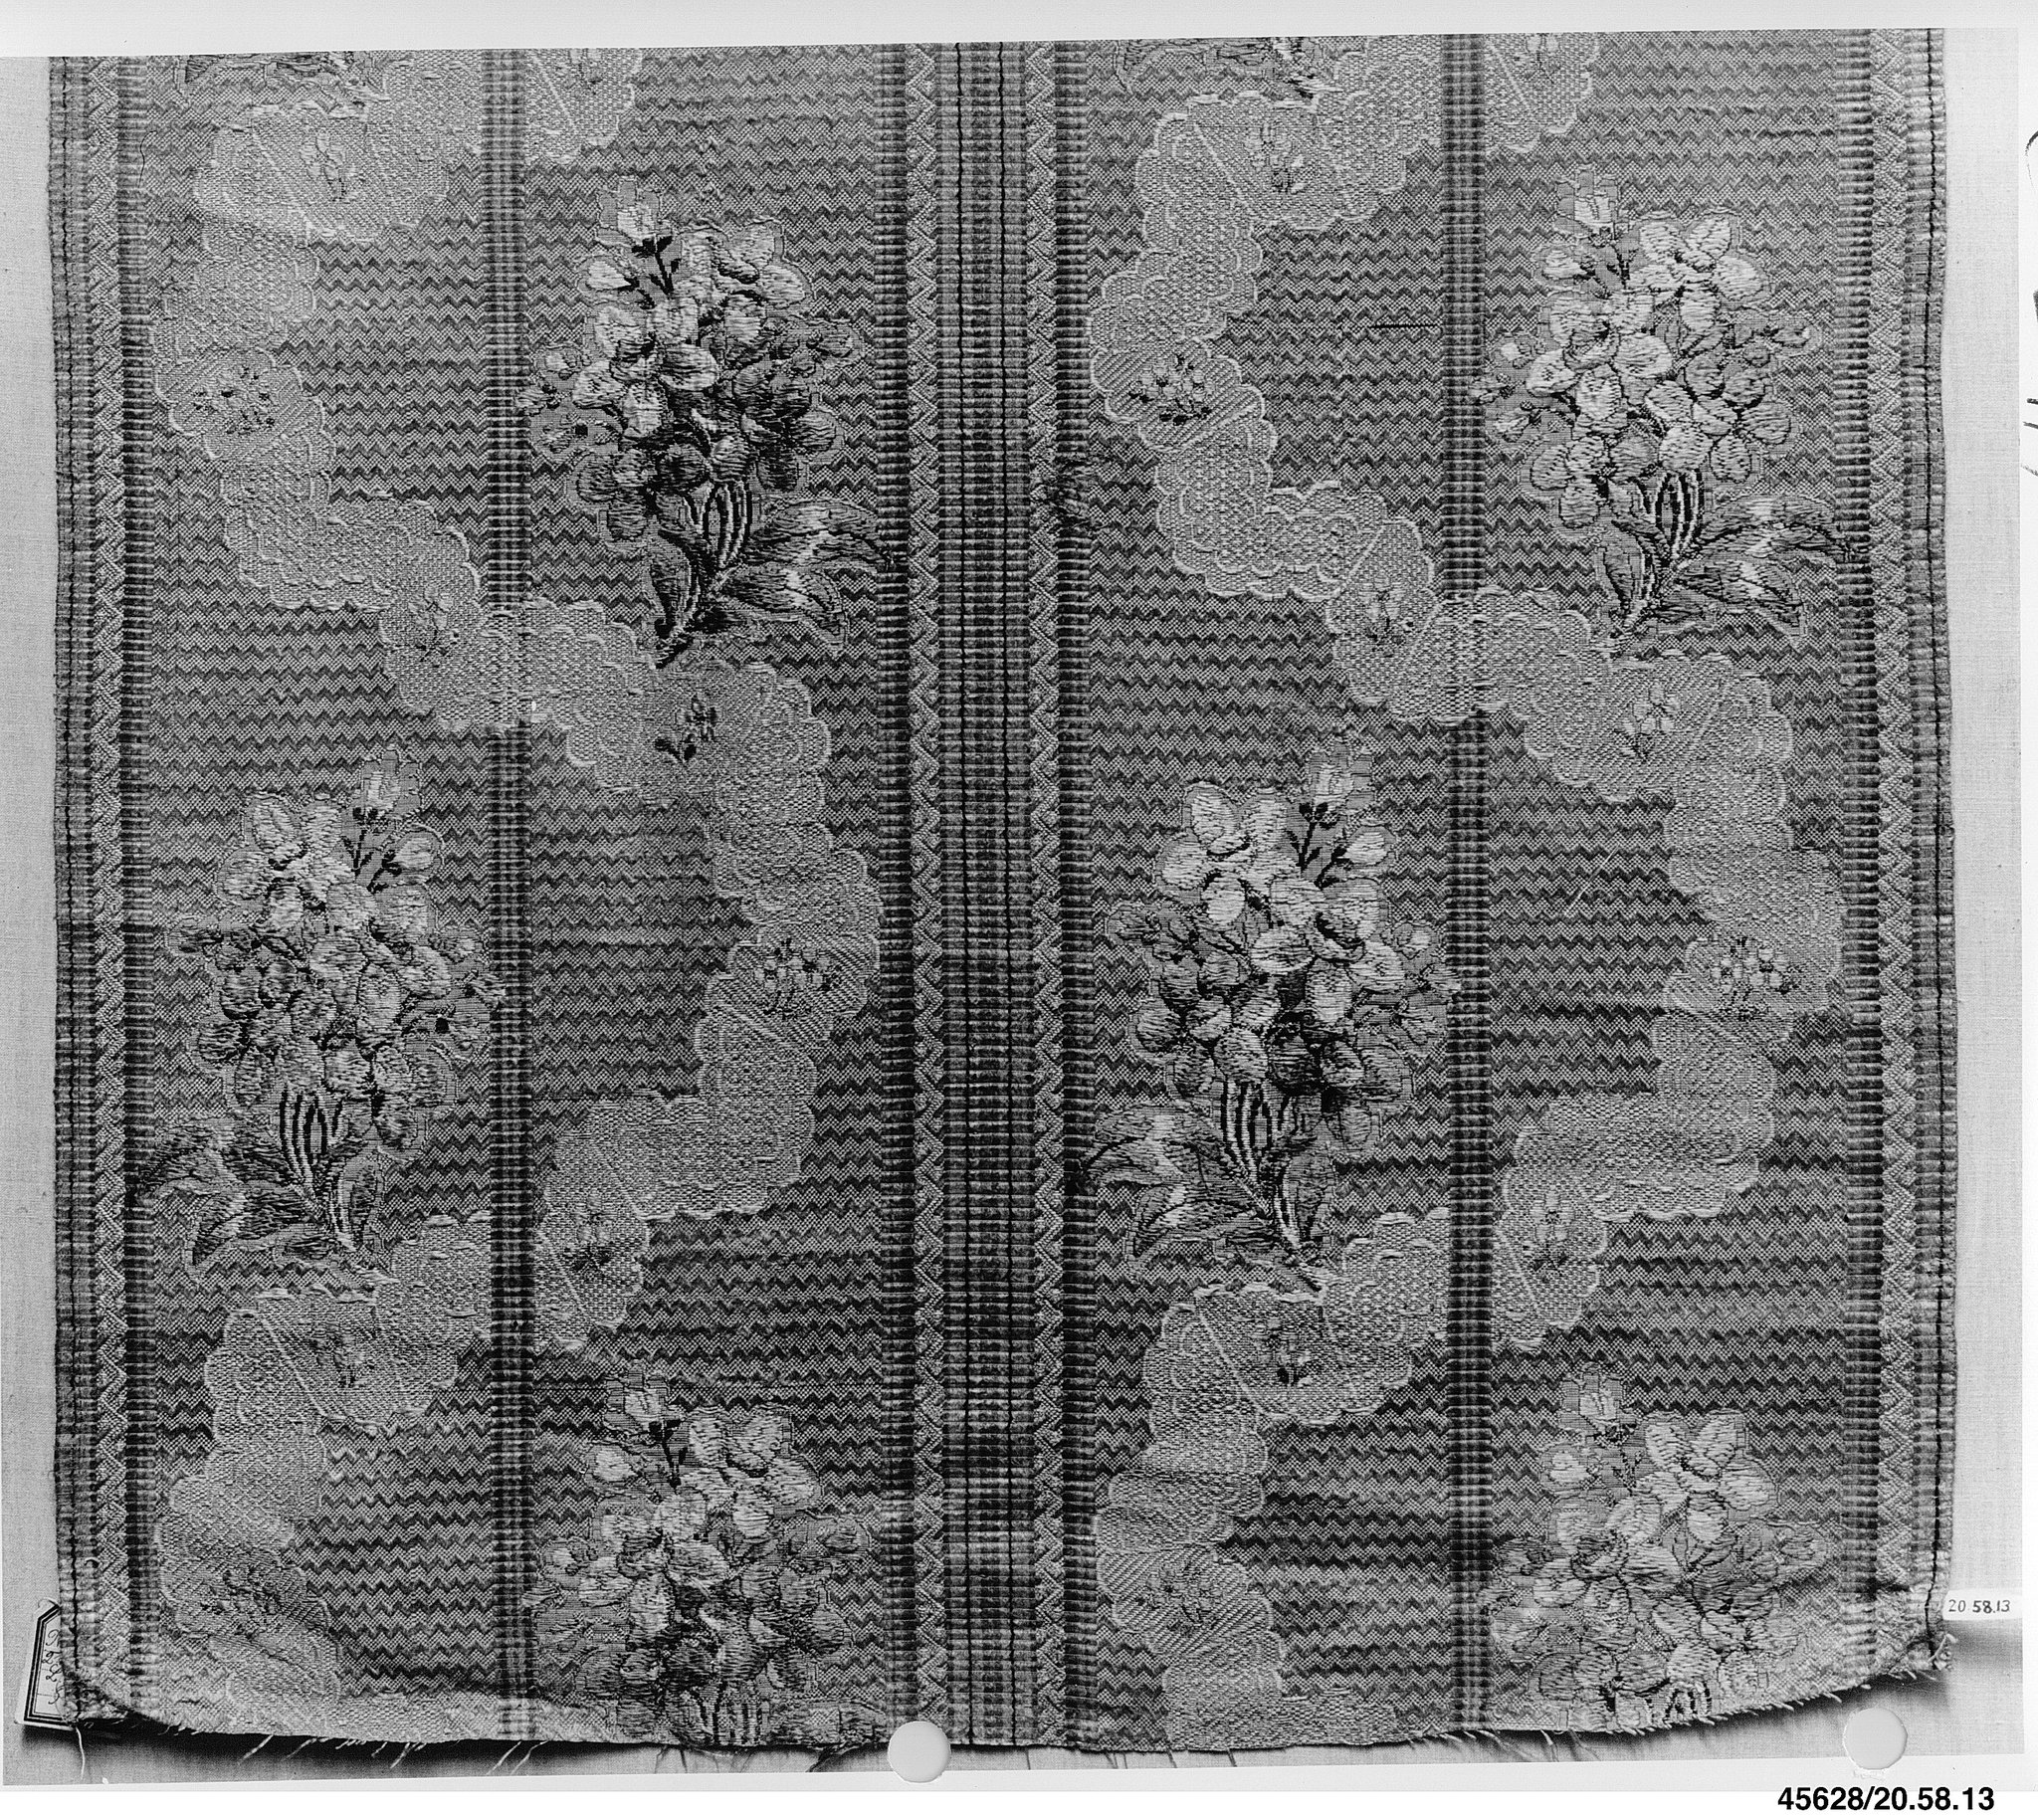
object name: piece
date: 1765-1770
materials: silk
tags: flowers,leaves